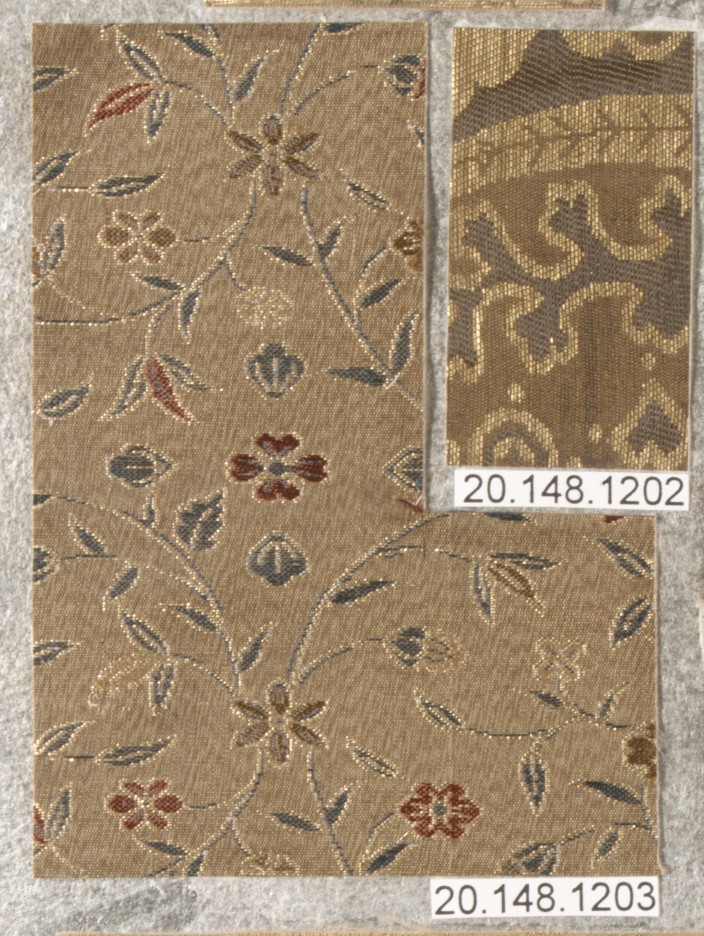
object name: piece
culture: japanese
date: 1701-1800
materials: silk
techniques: compound weave